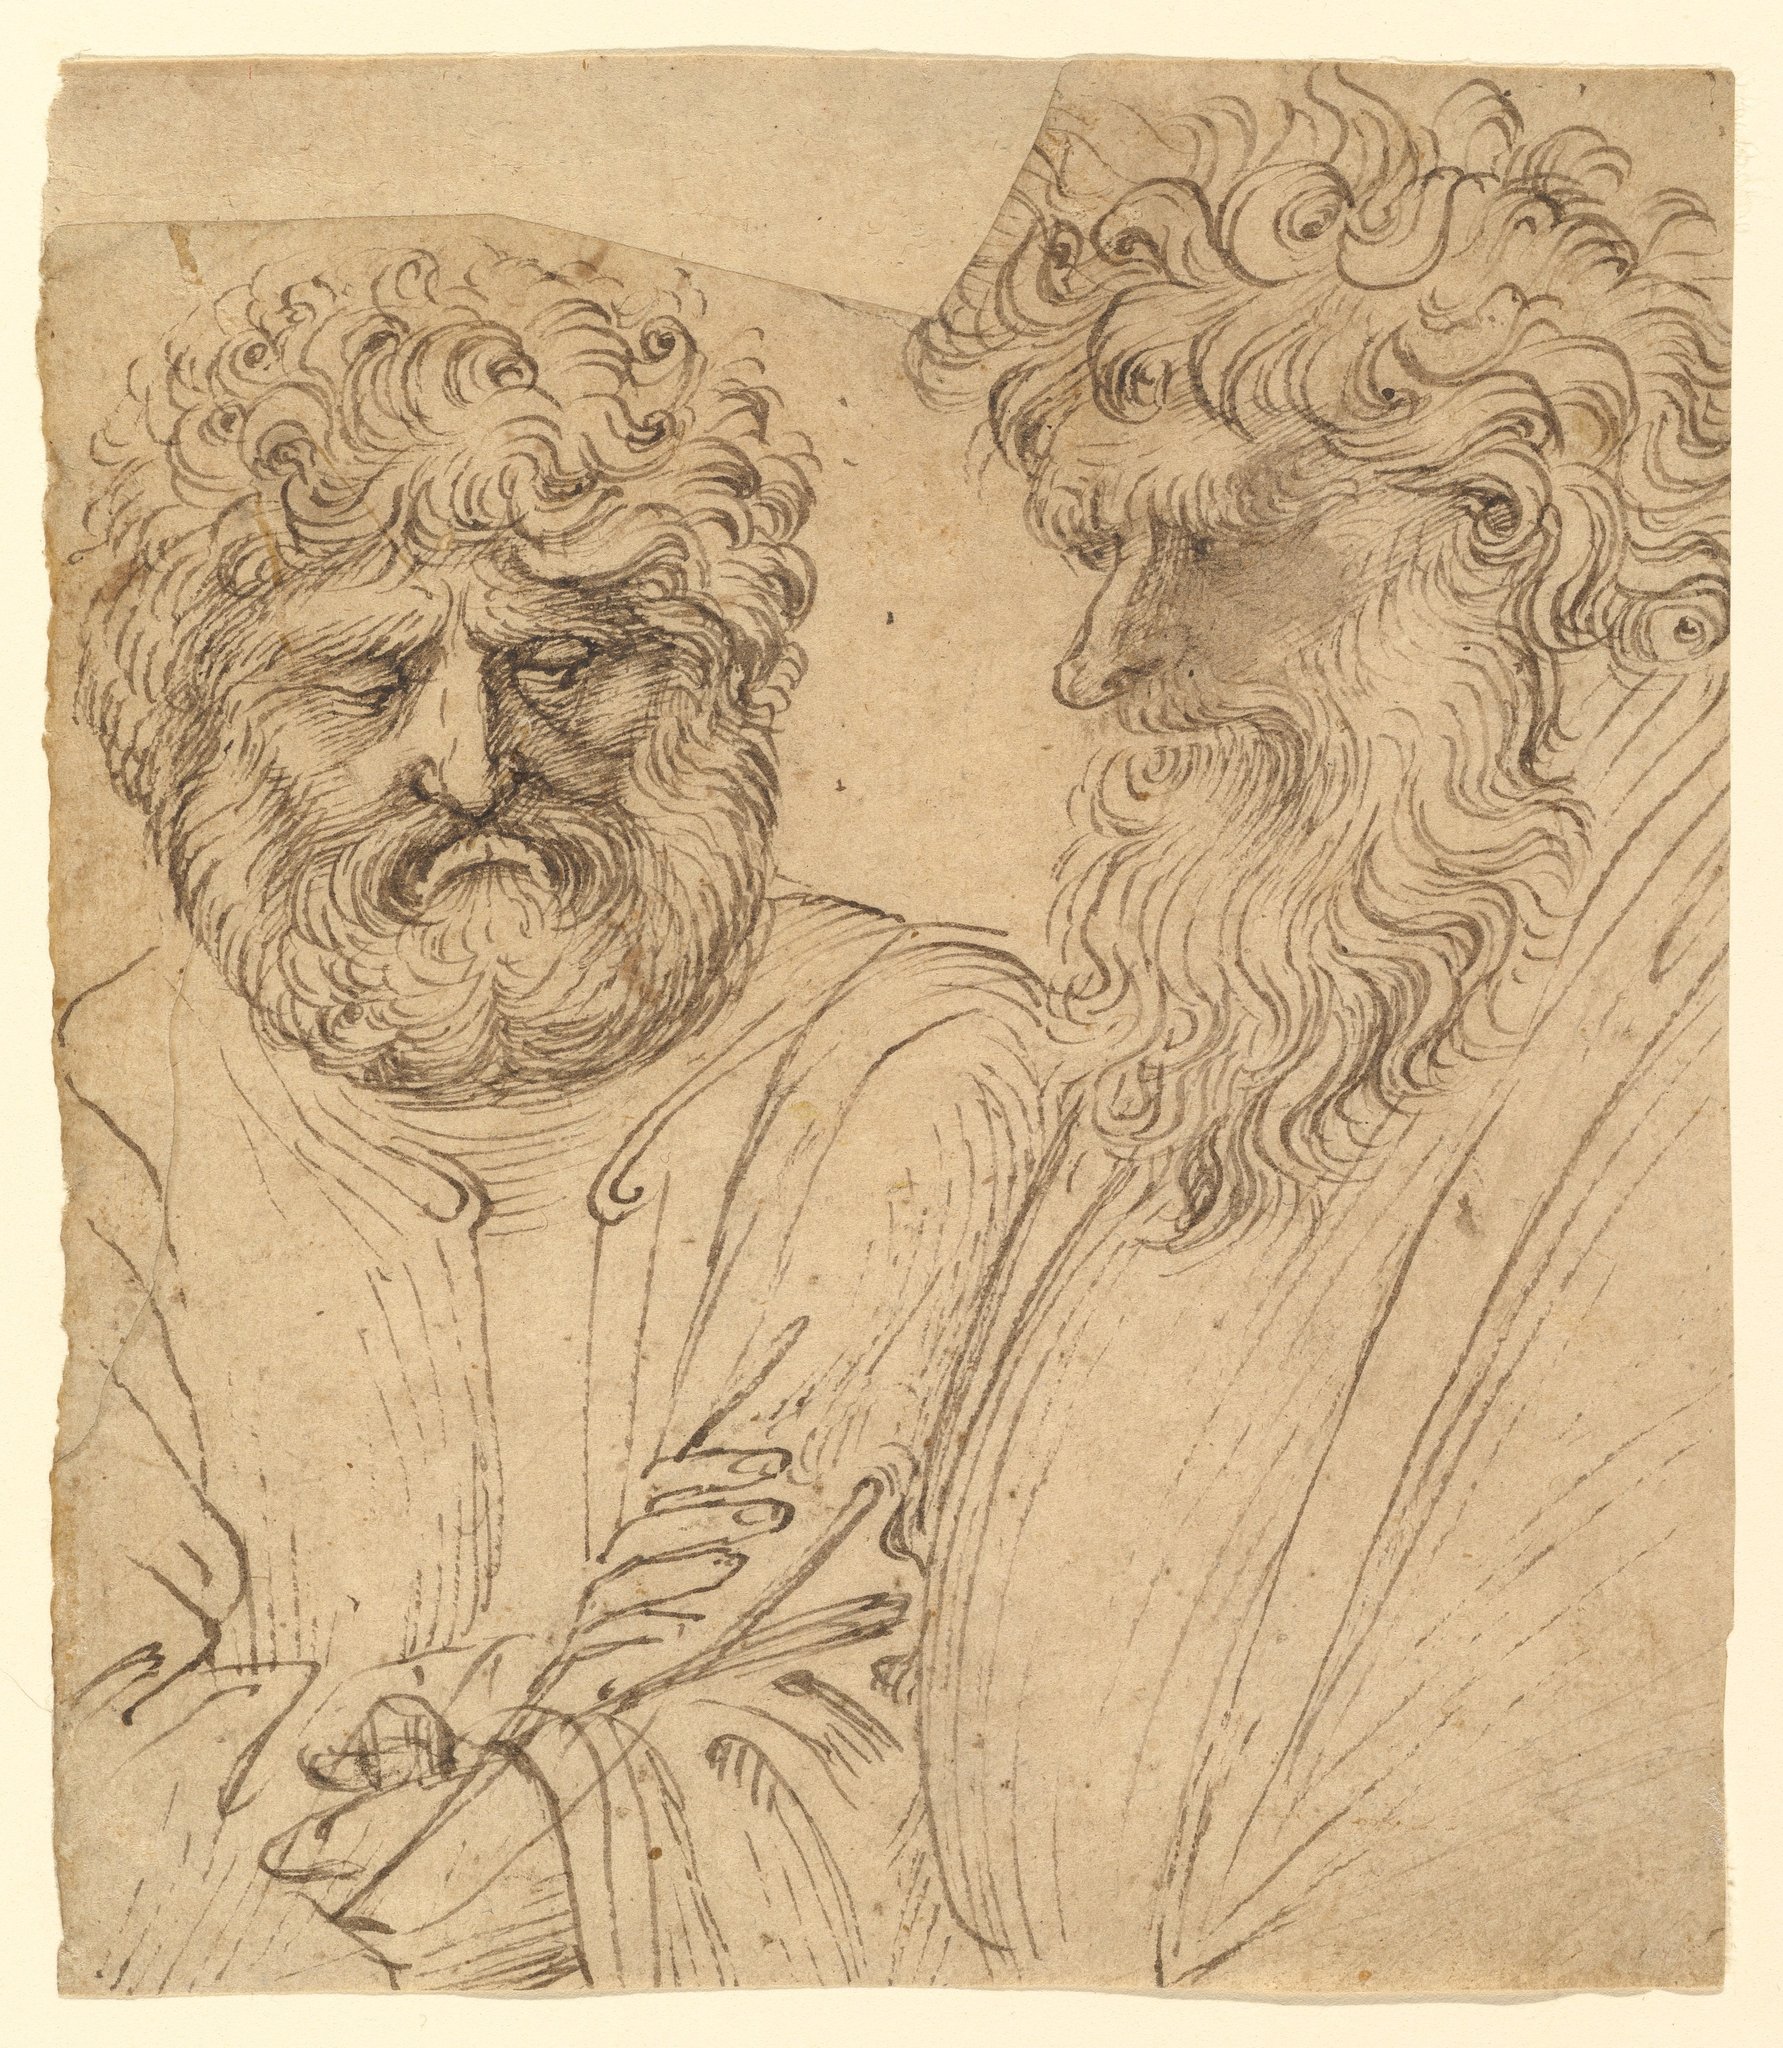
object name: drawing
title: Two Heavily Bearded Men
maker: stefano da verona (stefano di giovanni d'arbosio di francia)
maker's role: artist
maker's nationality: italian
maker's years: 1374-1438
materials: ink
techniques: pen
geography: italy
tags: men,profiles